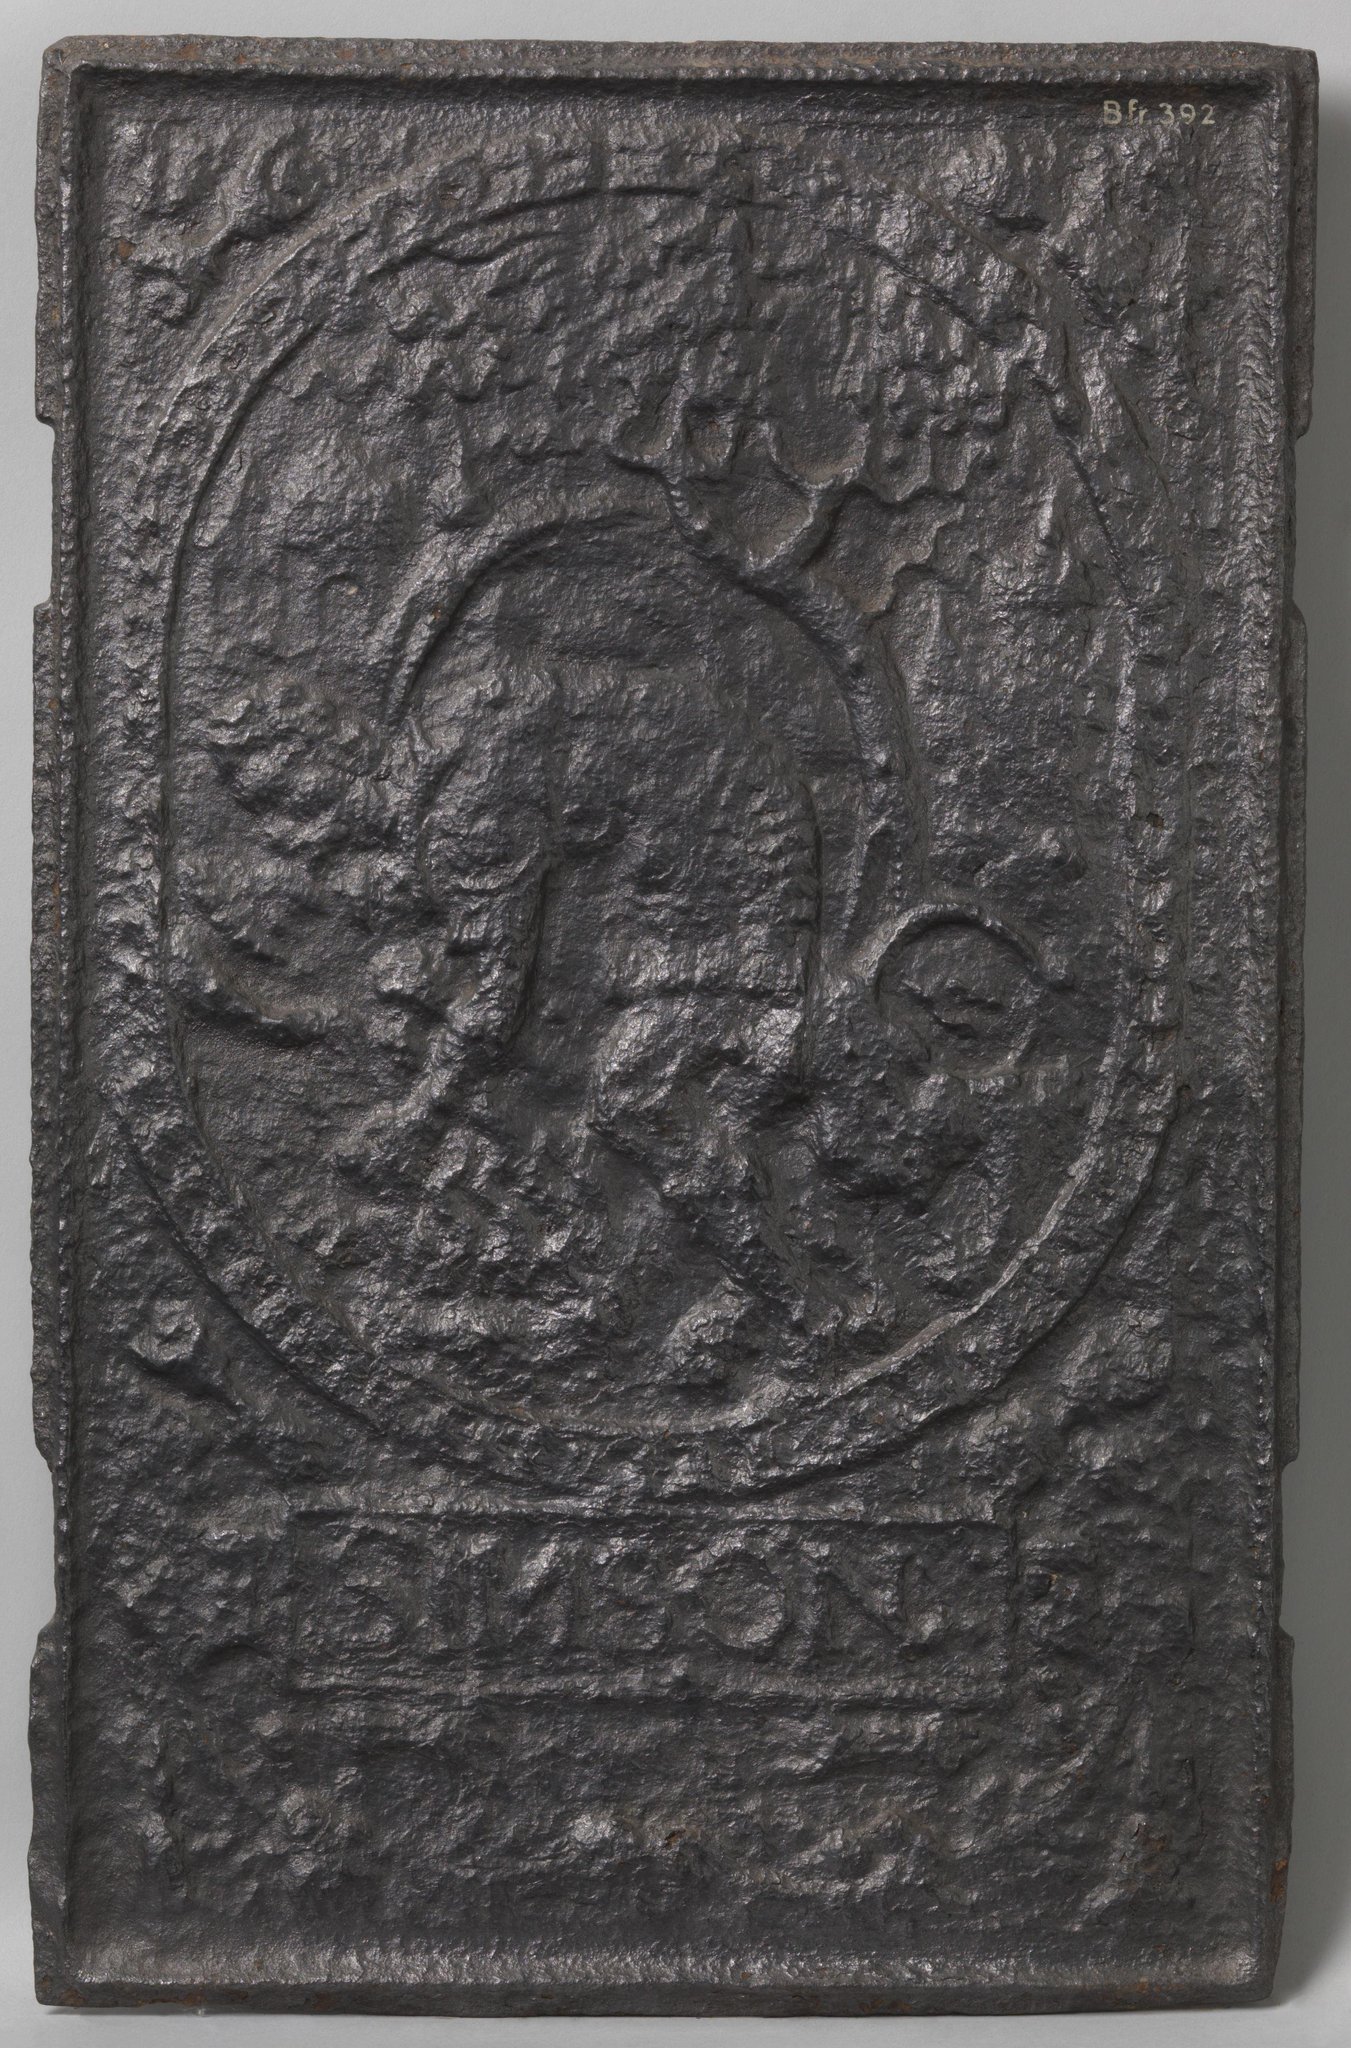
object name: stove plate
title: Kachelplaat met Samson en de leeuw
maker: Anonymous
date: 1575-1625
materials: iron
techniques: casting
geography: germany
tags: samson kills the lion with his bare hands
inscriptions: inscription: ‘SIMSON’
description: Kachelplaat van gietijzer. Centraal een ovaal medaillon met de afbeelding van een voorovergebogen Samson, die de leeuw doodt. Daaronder een rechthoekig cartouche met de naam Simson. De bovenhoeken en de ruimte rond het cartouche zijn gevuld met rankwerk.